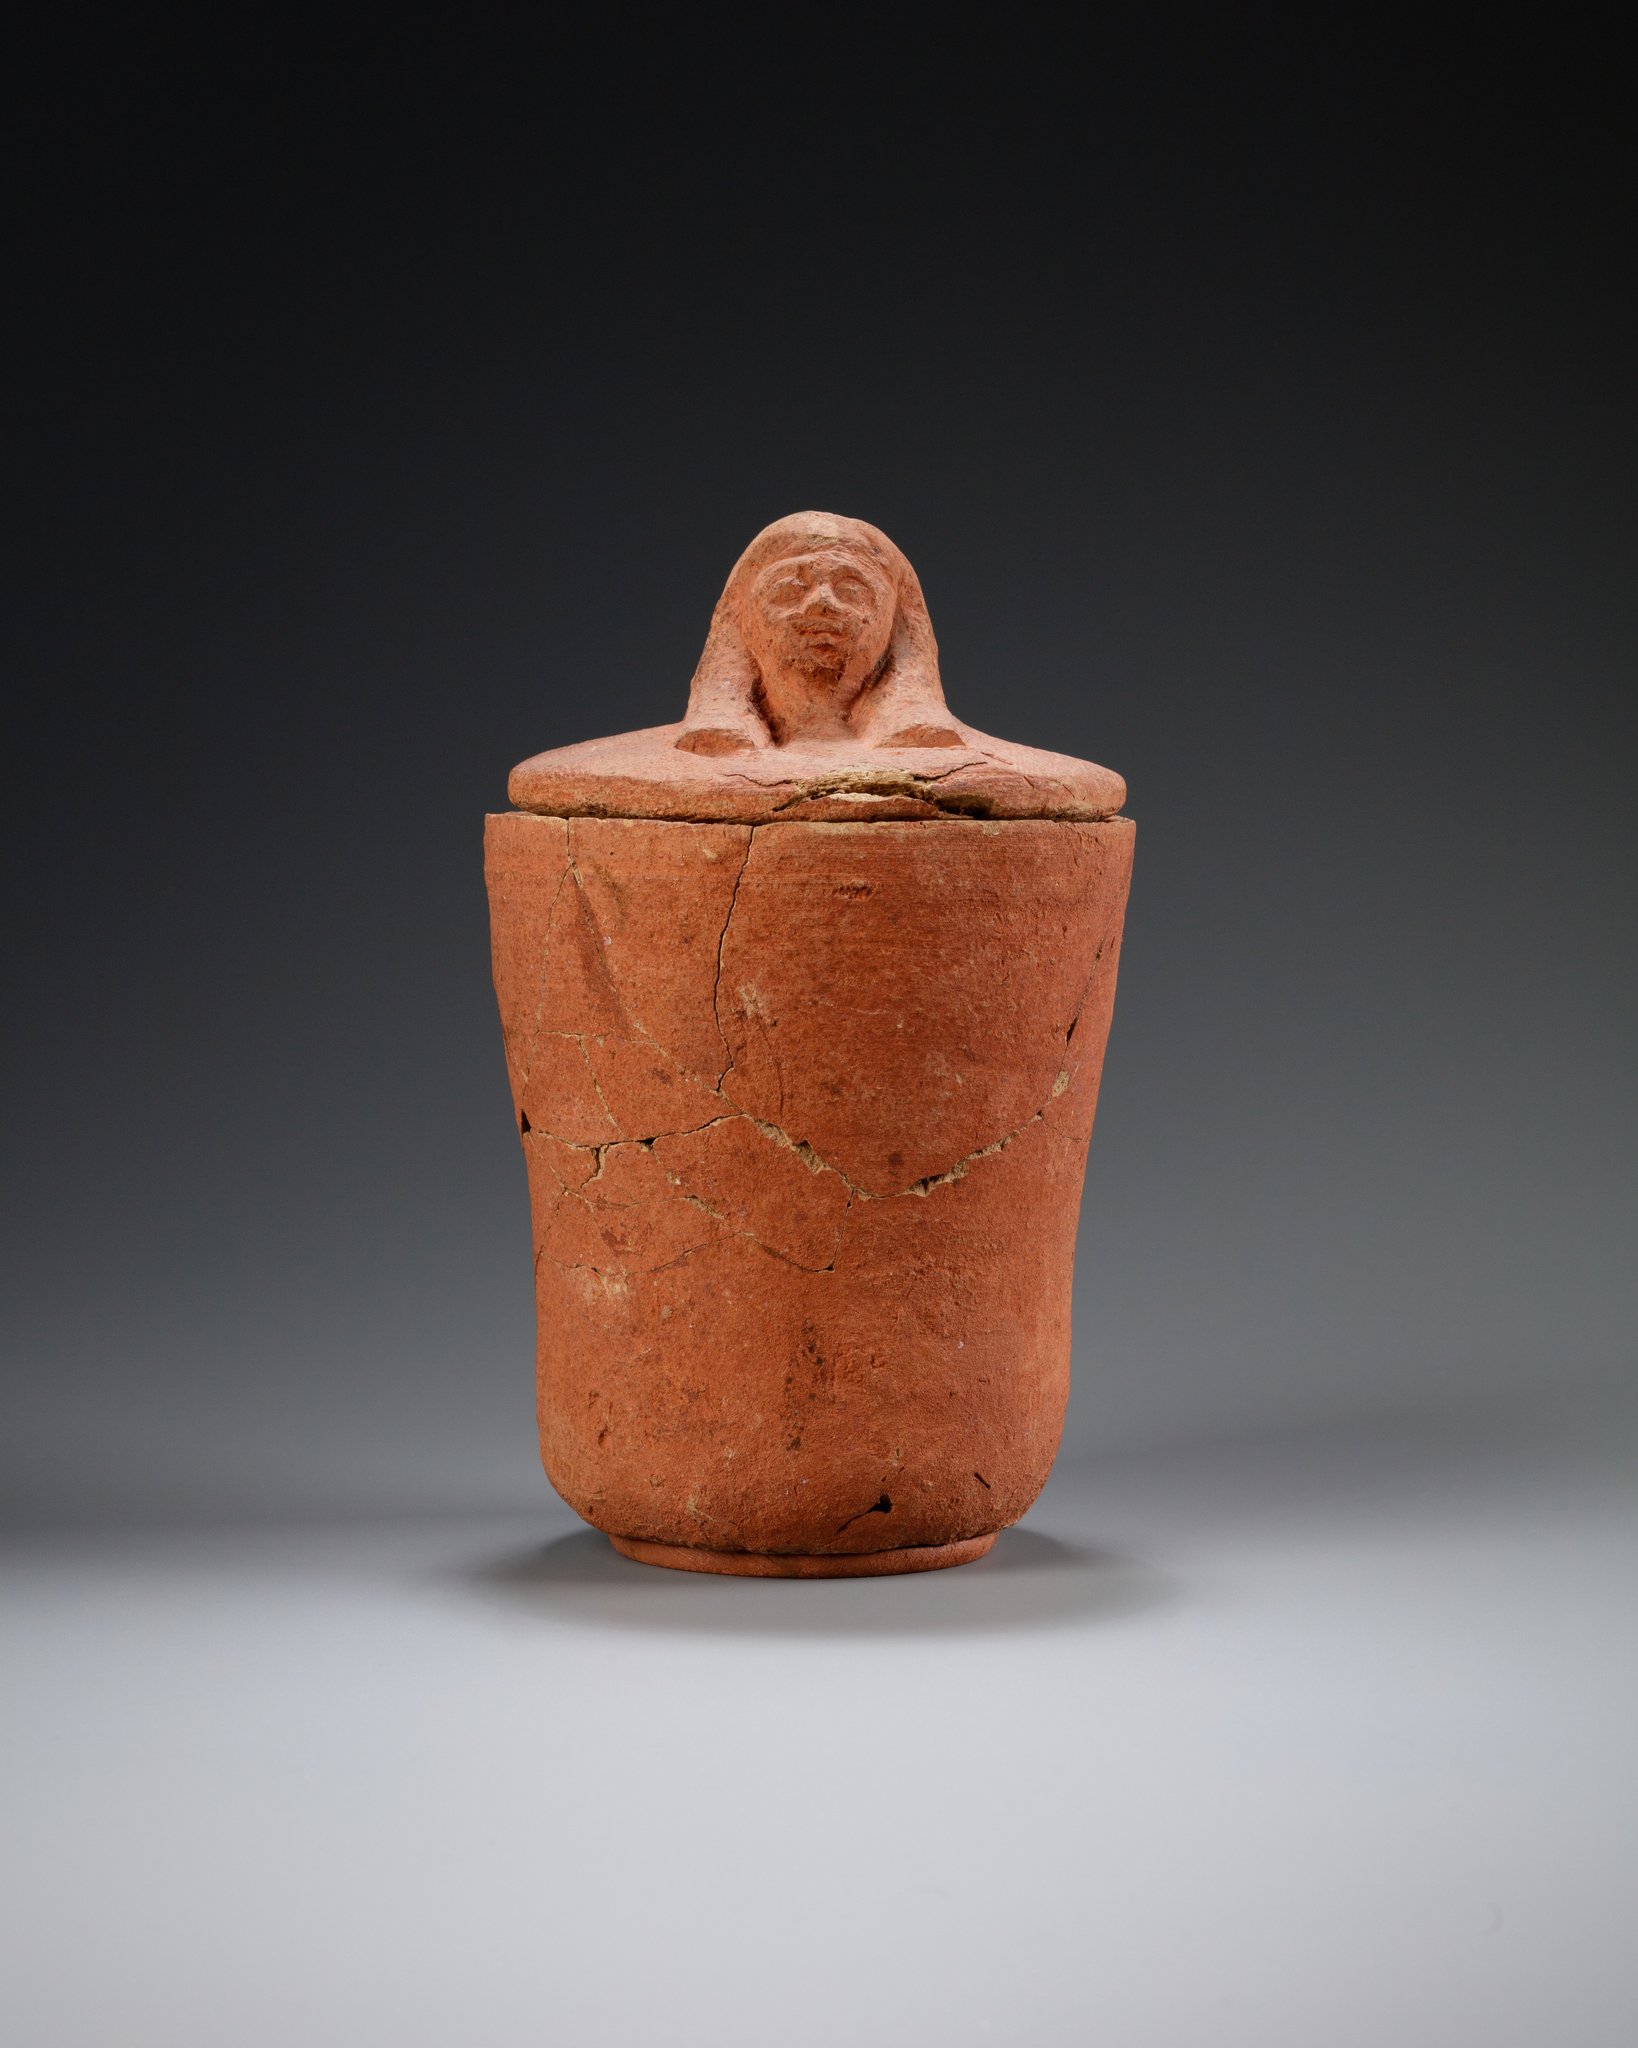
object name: canopic jar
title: Canopic jar with human head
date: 664-332 BCE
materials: paint, pottery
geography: egypt